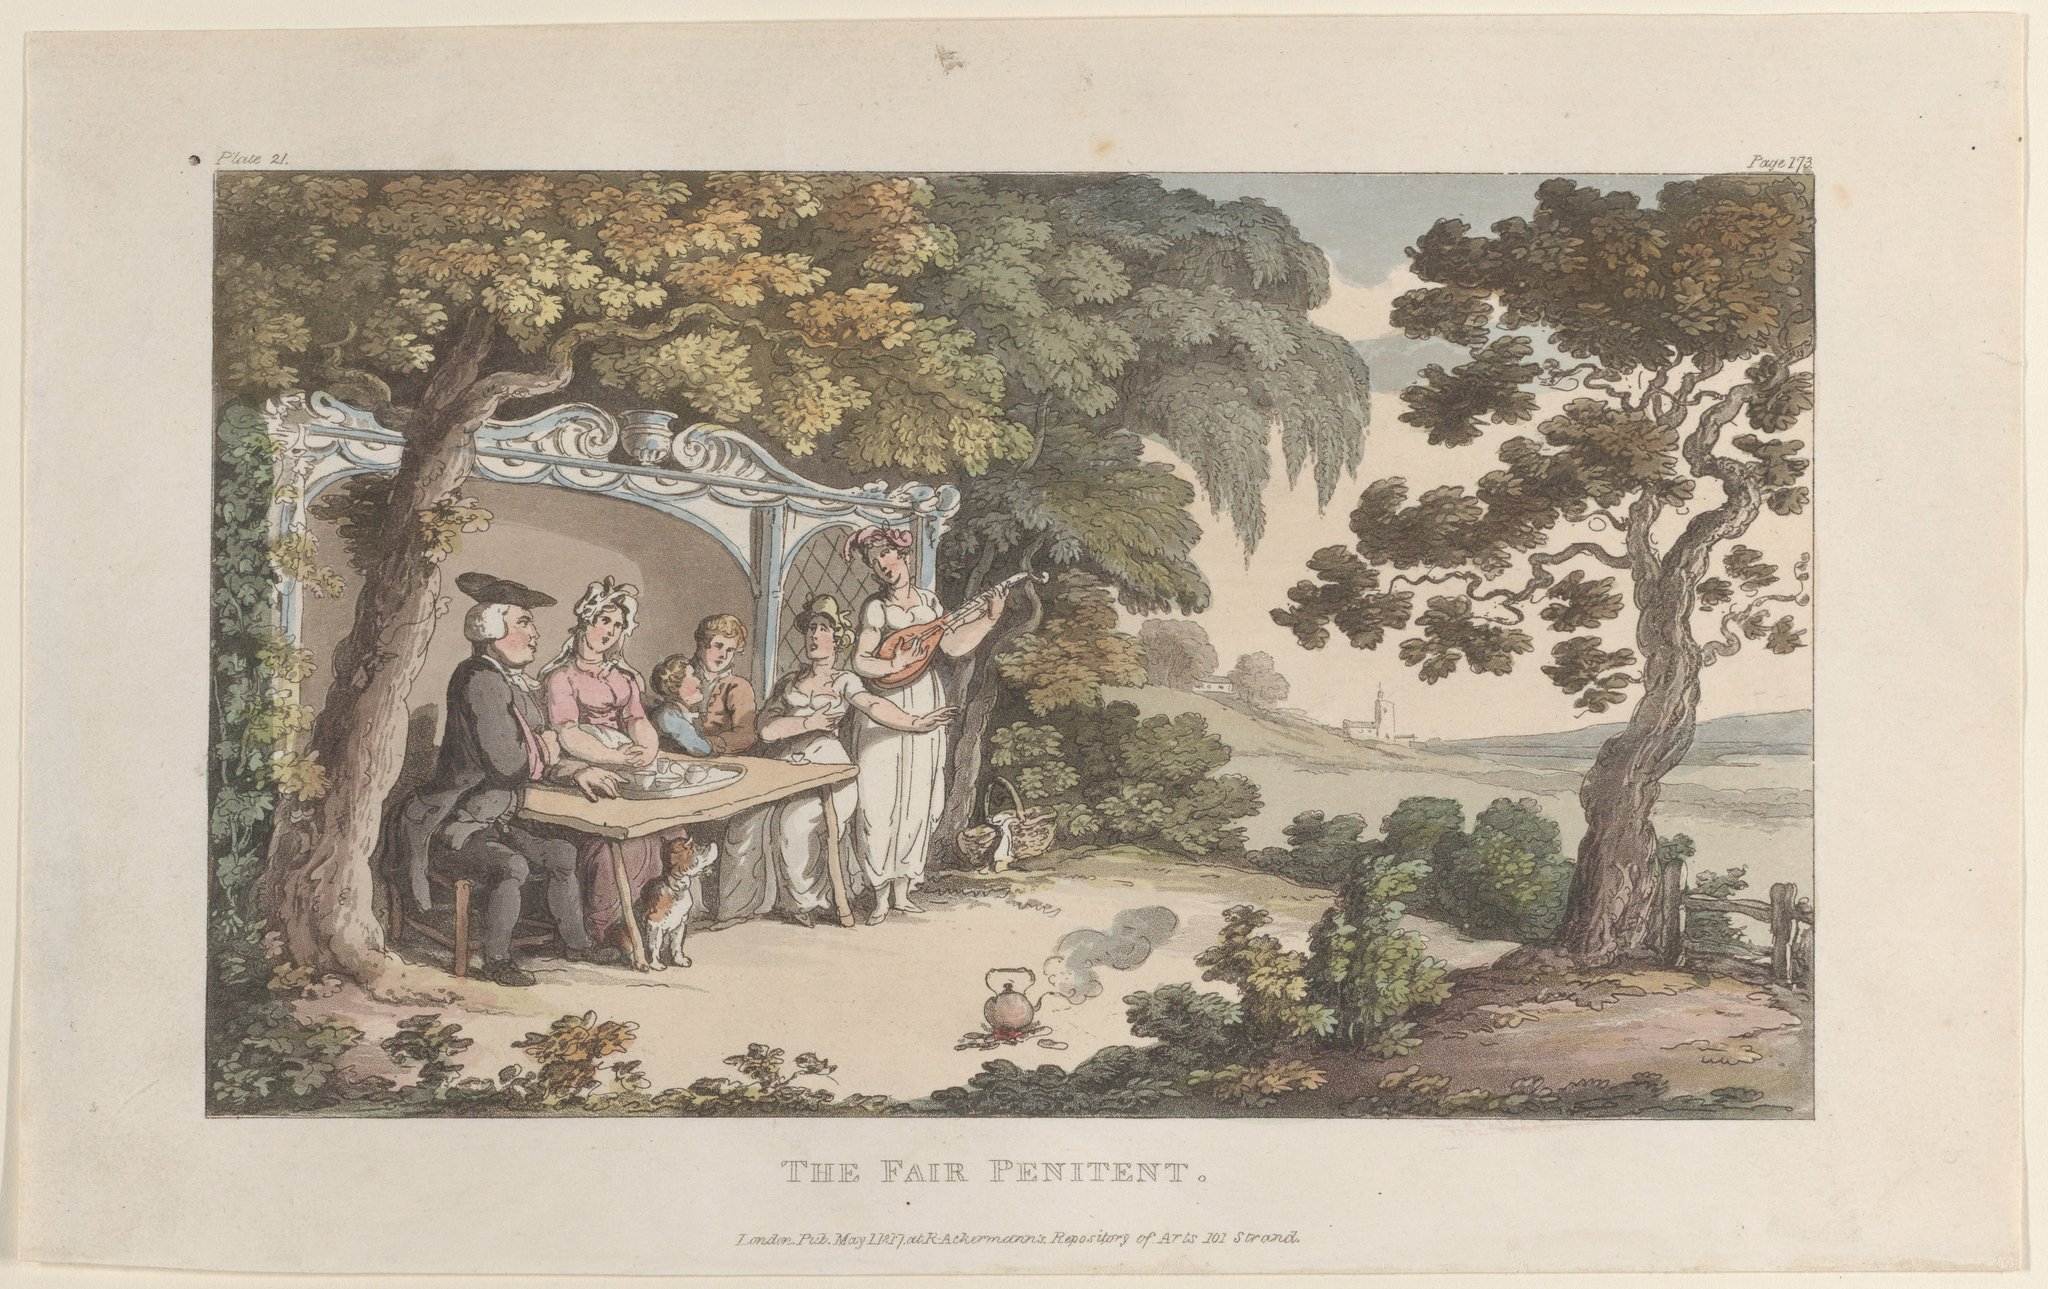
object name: print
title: The Fair Penitent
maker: thomas rowlandson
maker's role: artist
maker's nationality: british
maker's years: 1757-1827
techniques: aquatint, etching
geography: london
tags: men,women,landscapes